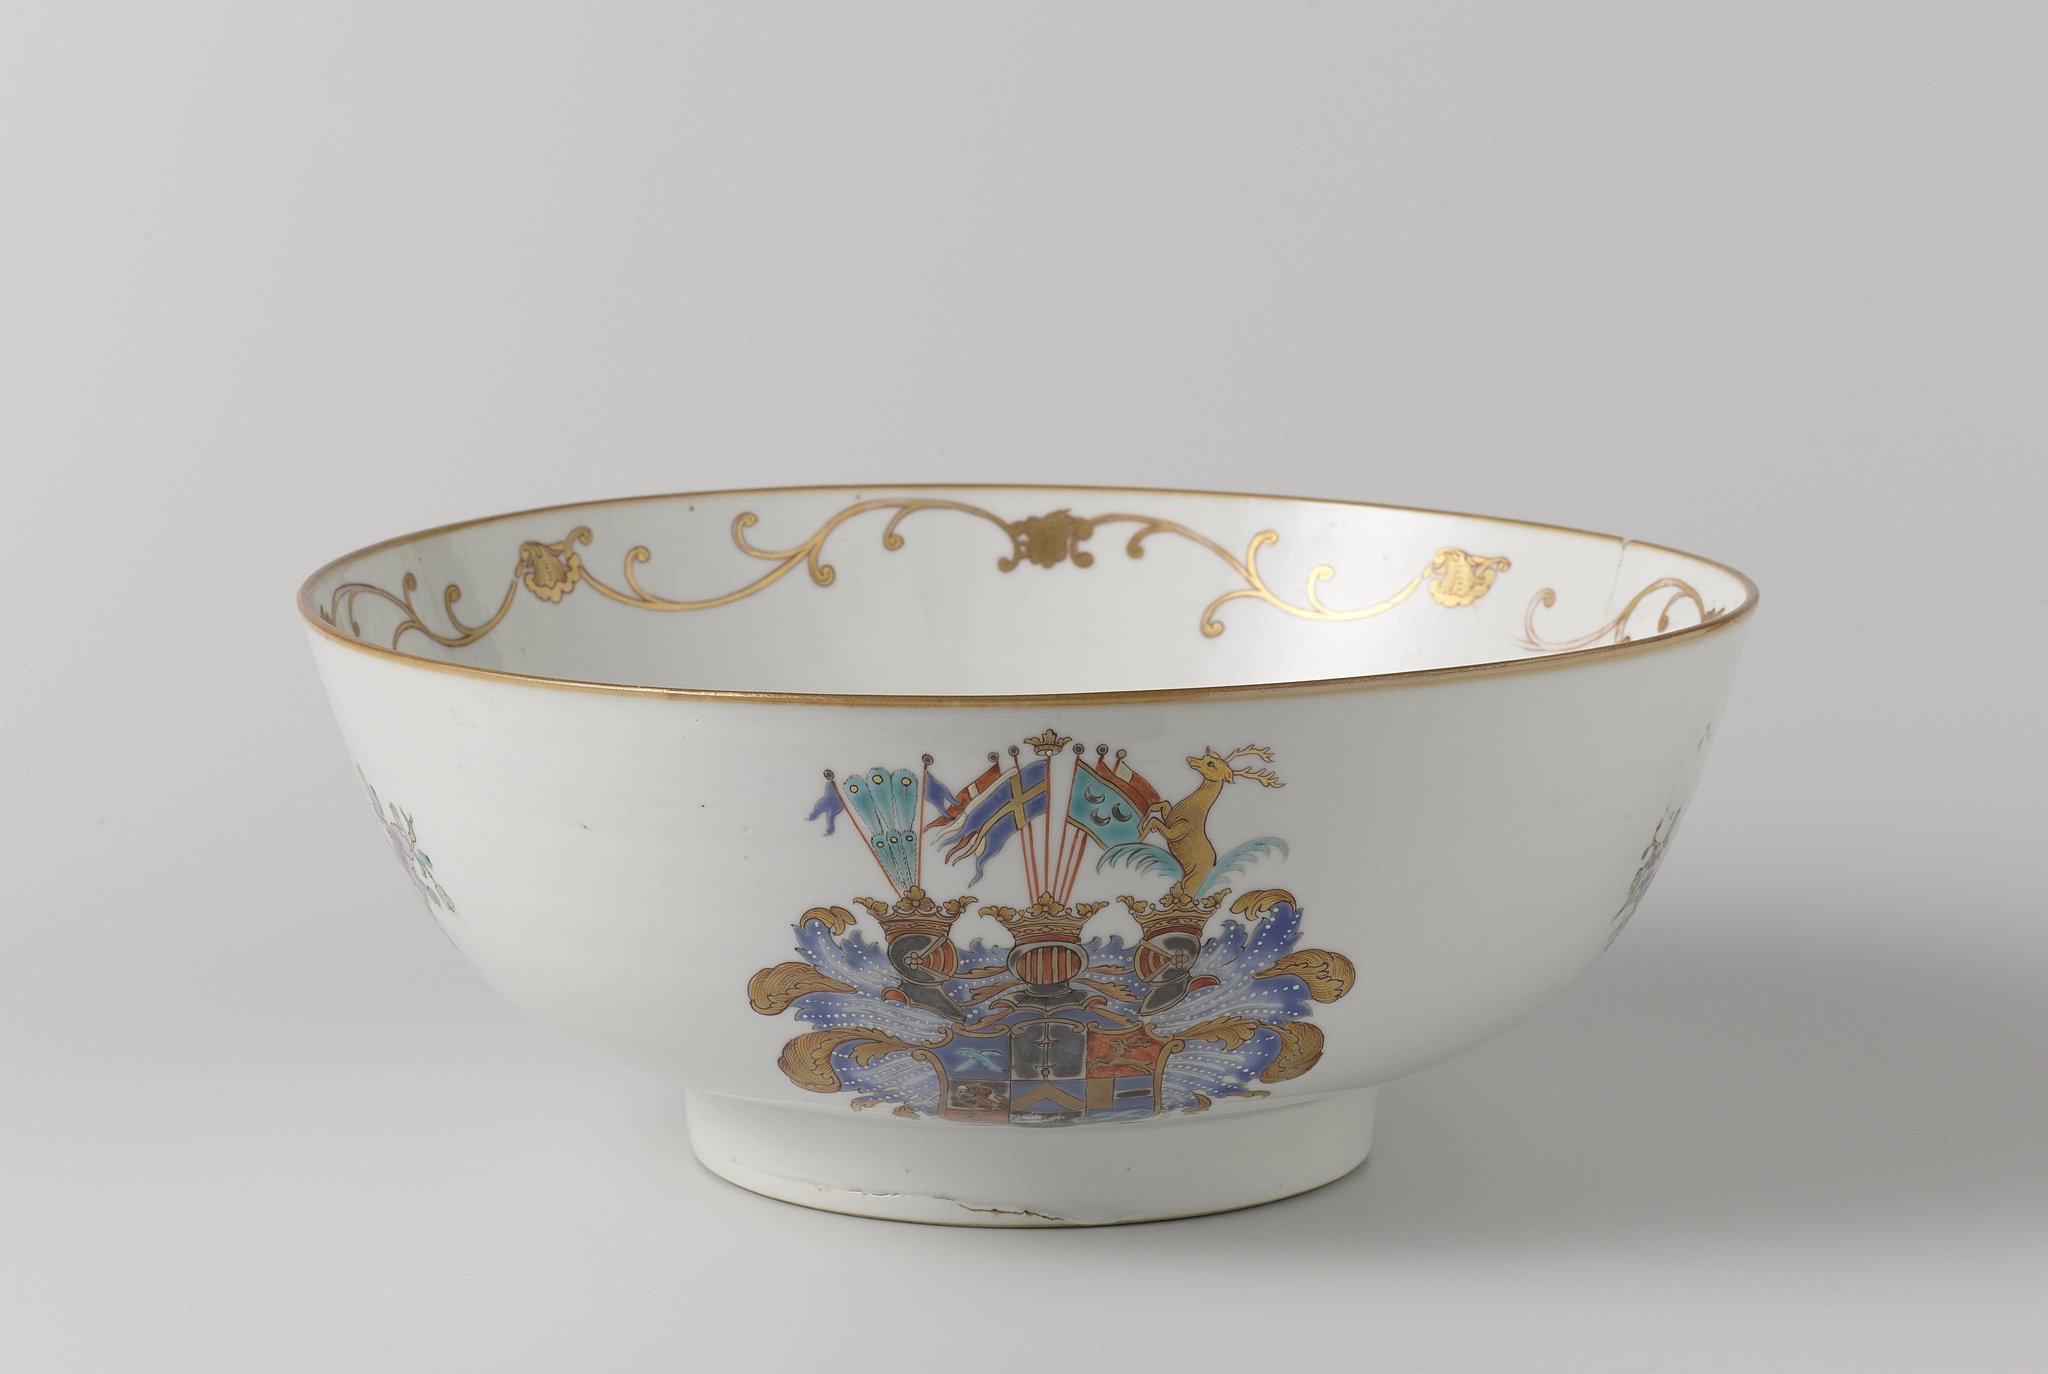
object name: bowl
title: Bowl with a coat of arms and European ornamental border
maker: Anonymous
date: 1740-1760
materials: glaze, gold, paint, porcelain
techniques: firing, gilding, turning, vitrification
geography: china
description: Kom met een rechte wand, beschilderd in emails en goud met twee maal een familiewapen en tweemaal een bloemtak. Gouden ranken langs de binnenrand.